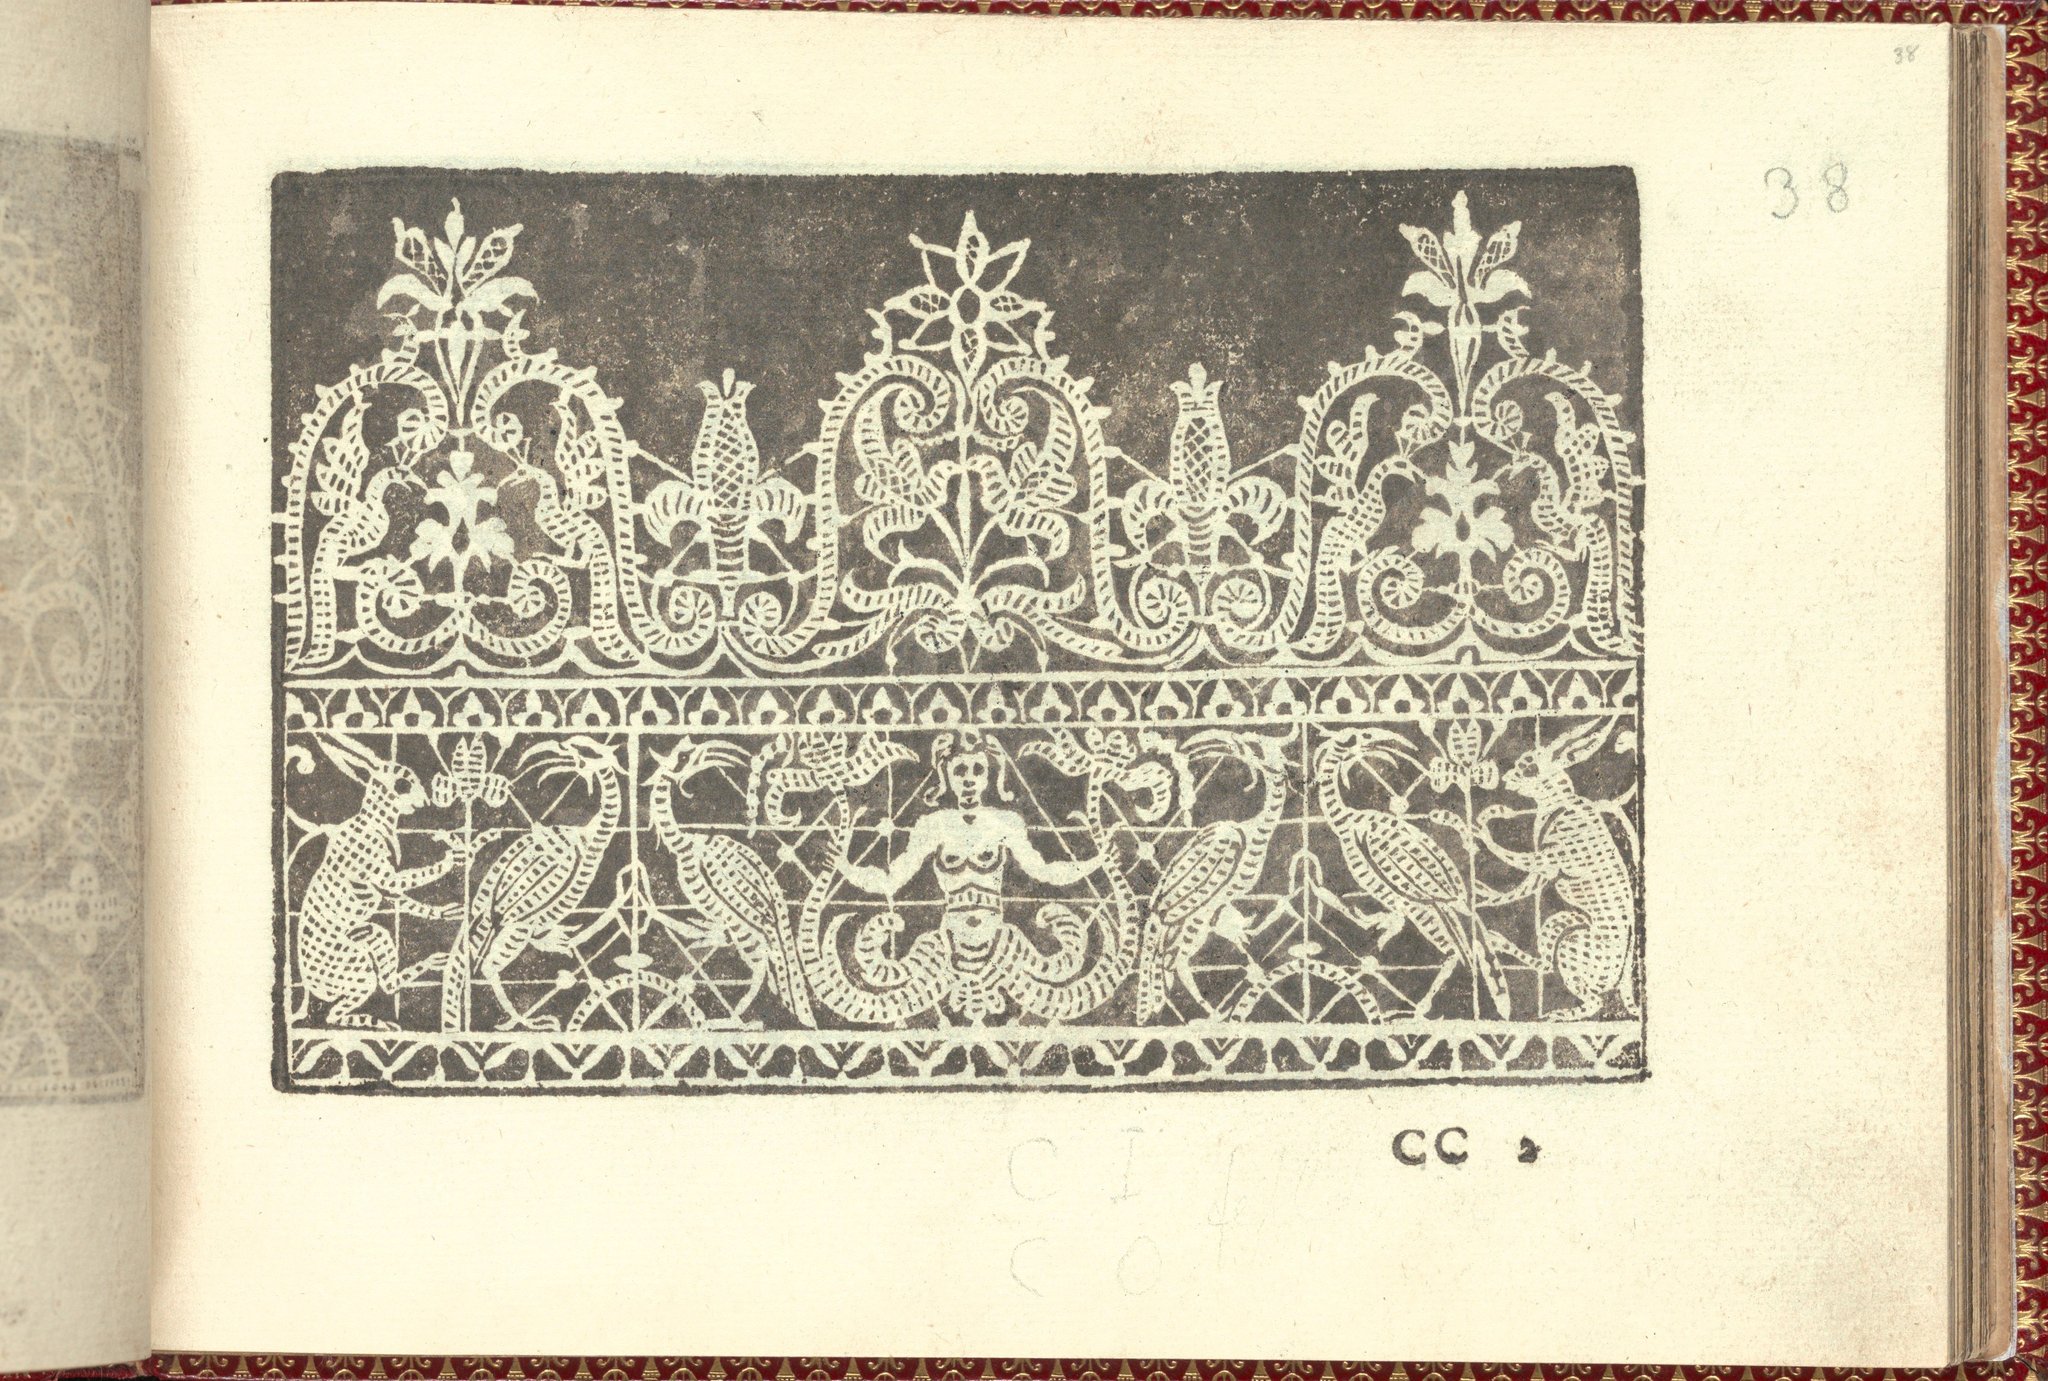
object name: book print ornament architecture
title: Corona delle Nobili et Virtuose Donne: Libro I-IV, page 38 (recto)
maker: cesare vecellio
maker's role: publisher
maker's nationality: italian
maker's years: 1521-1601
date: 1601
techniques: woodcut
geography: italy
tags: birds,male nudes,rabbits